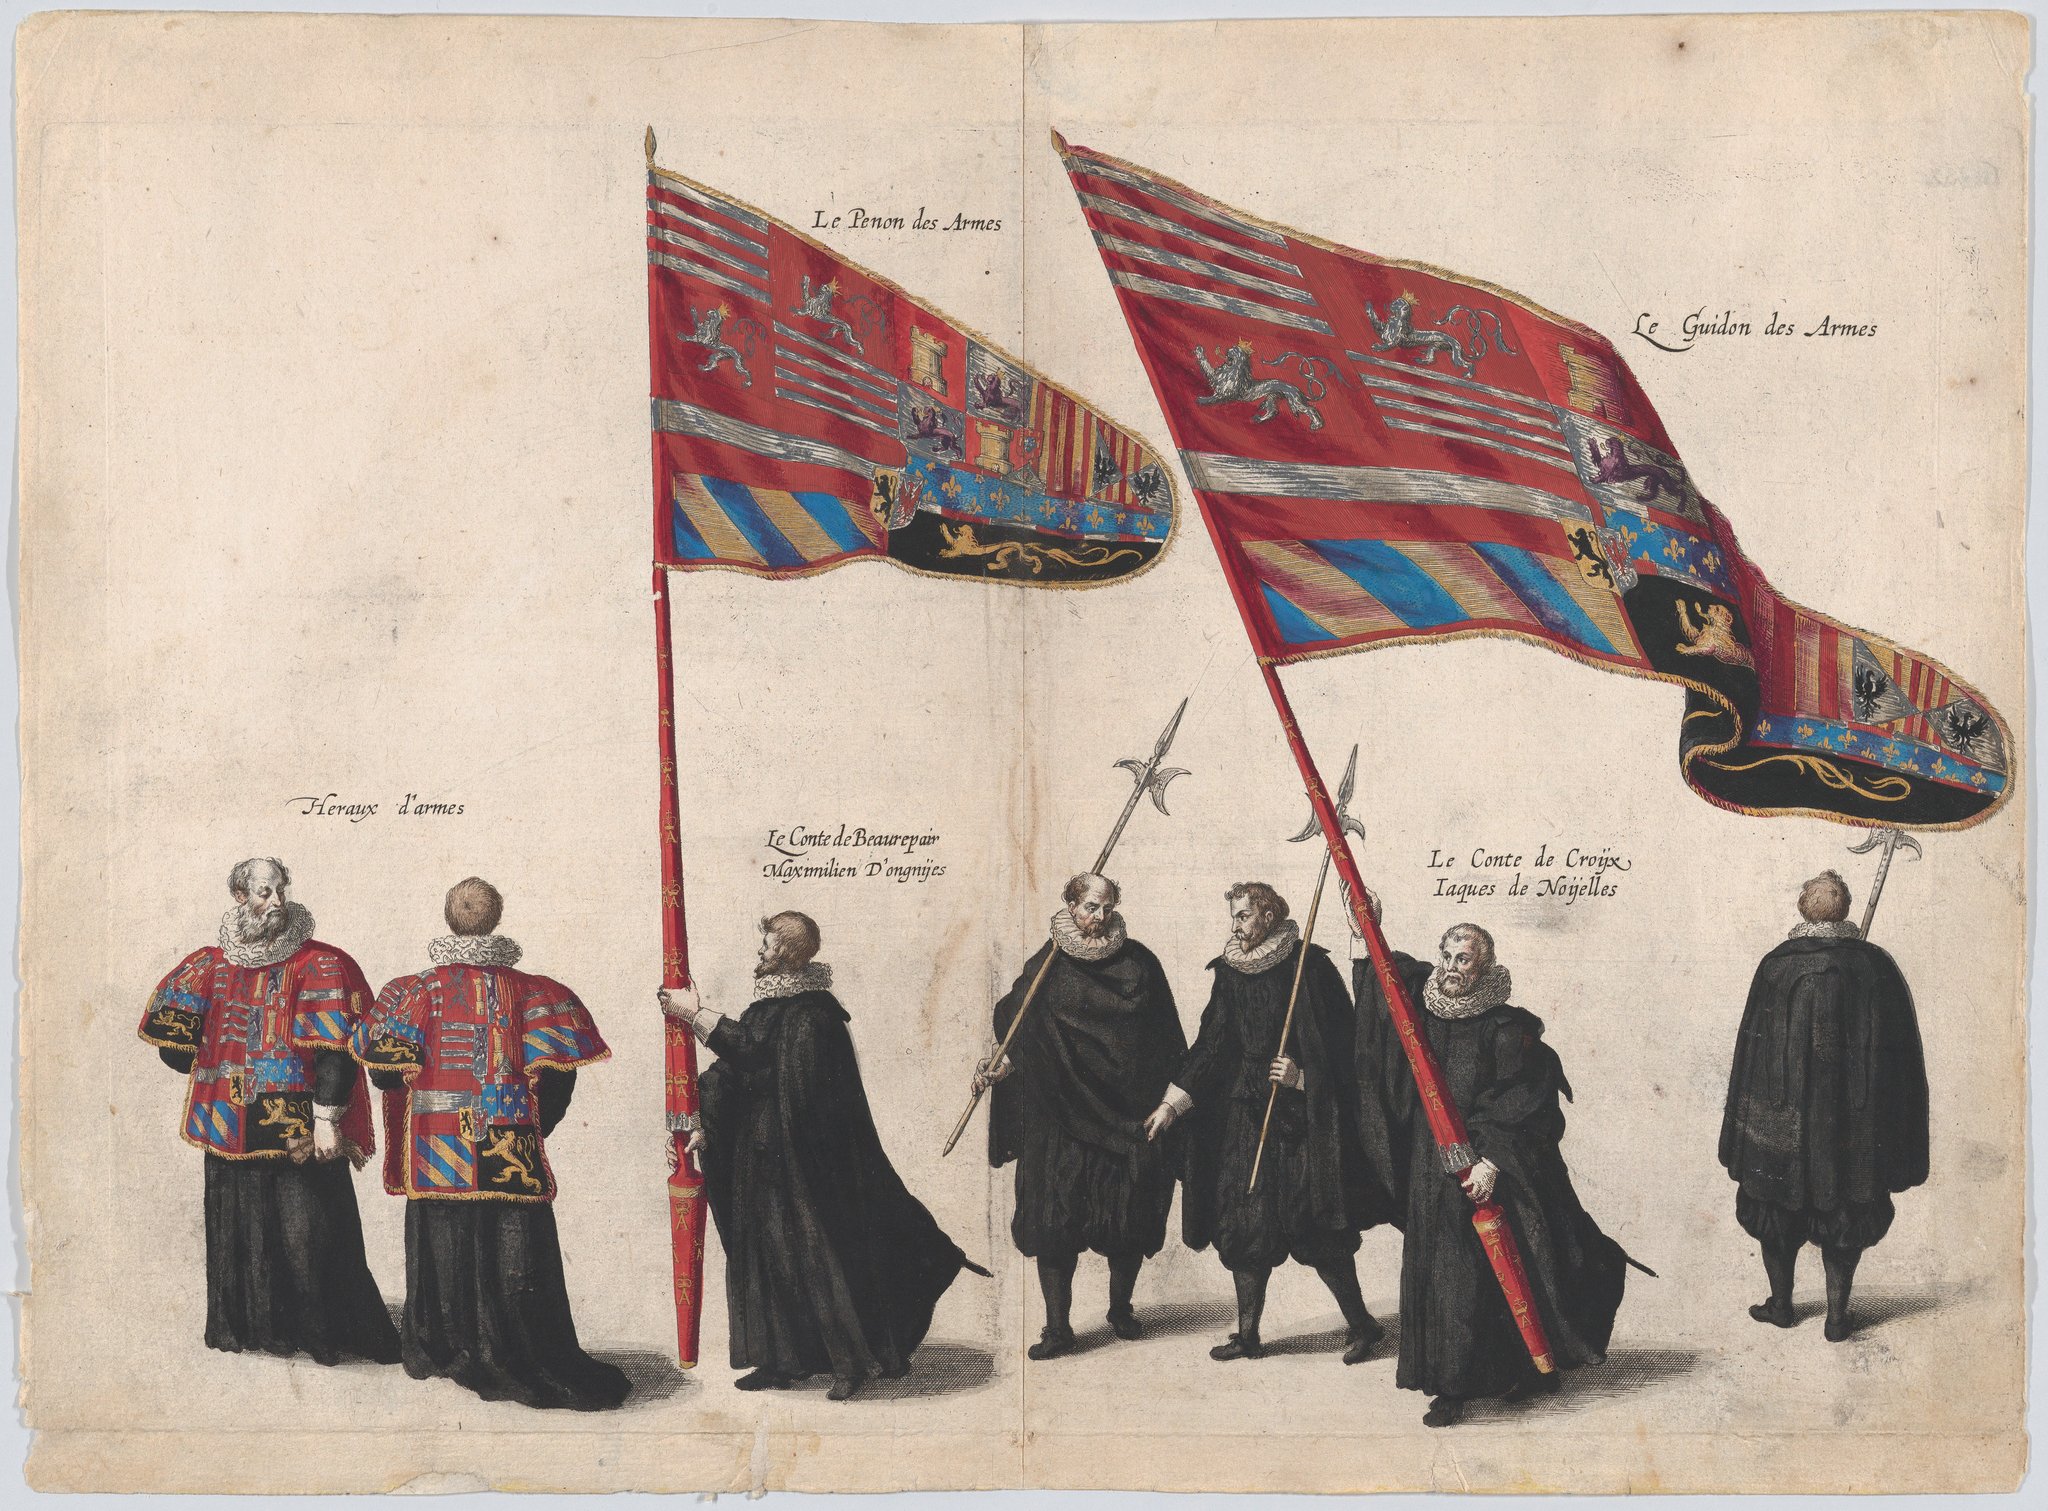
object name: print, fete, ornament architecture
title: Plate 48: Men bearing arms and heraldic flags marching in the funeral procession of Archduke Albert of Austria; from 'Pompa Funebris ... Alberti Pii'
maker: cornelis galle (i)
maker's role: artist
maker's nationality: netherlandish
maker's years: 1576-1650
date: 1623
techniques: etching, hand coloring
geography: brussels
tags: weapons,men,flags,insignia